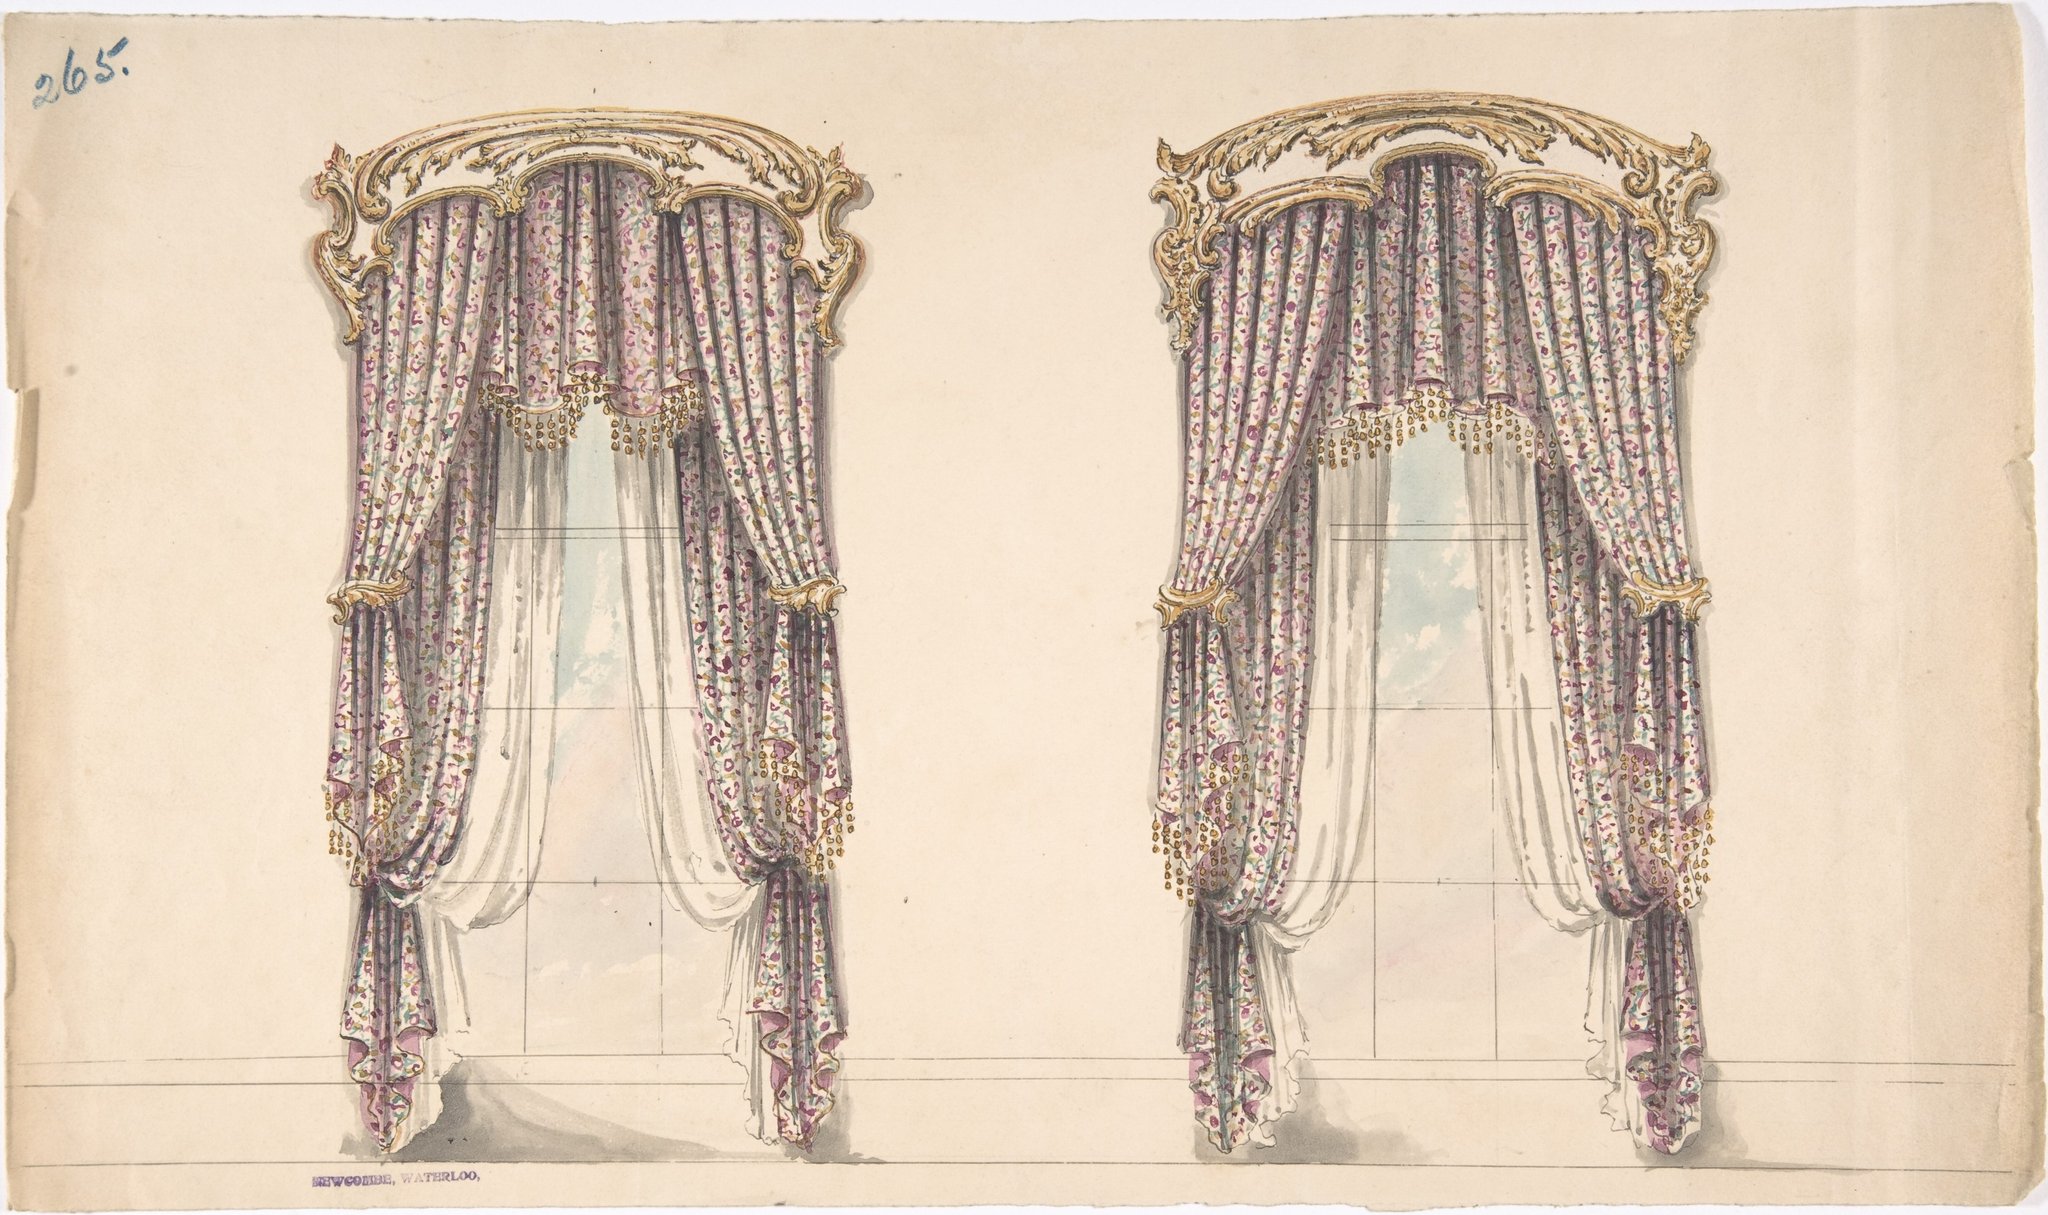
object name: drawing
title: Design for Pink, Mauve and White Floral Curtains with a Gold and White Pediment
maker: anonymous, british, 19th century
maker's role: artist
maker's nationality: british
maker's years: 1800-1900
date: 1801-1833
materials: ink, watercolor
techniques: brush, pen, wash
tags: curtains